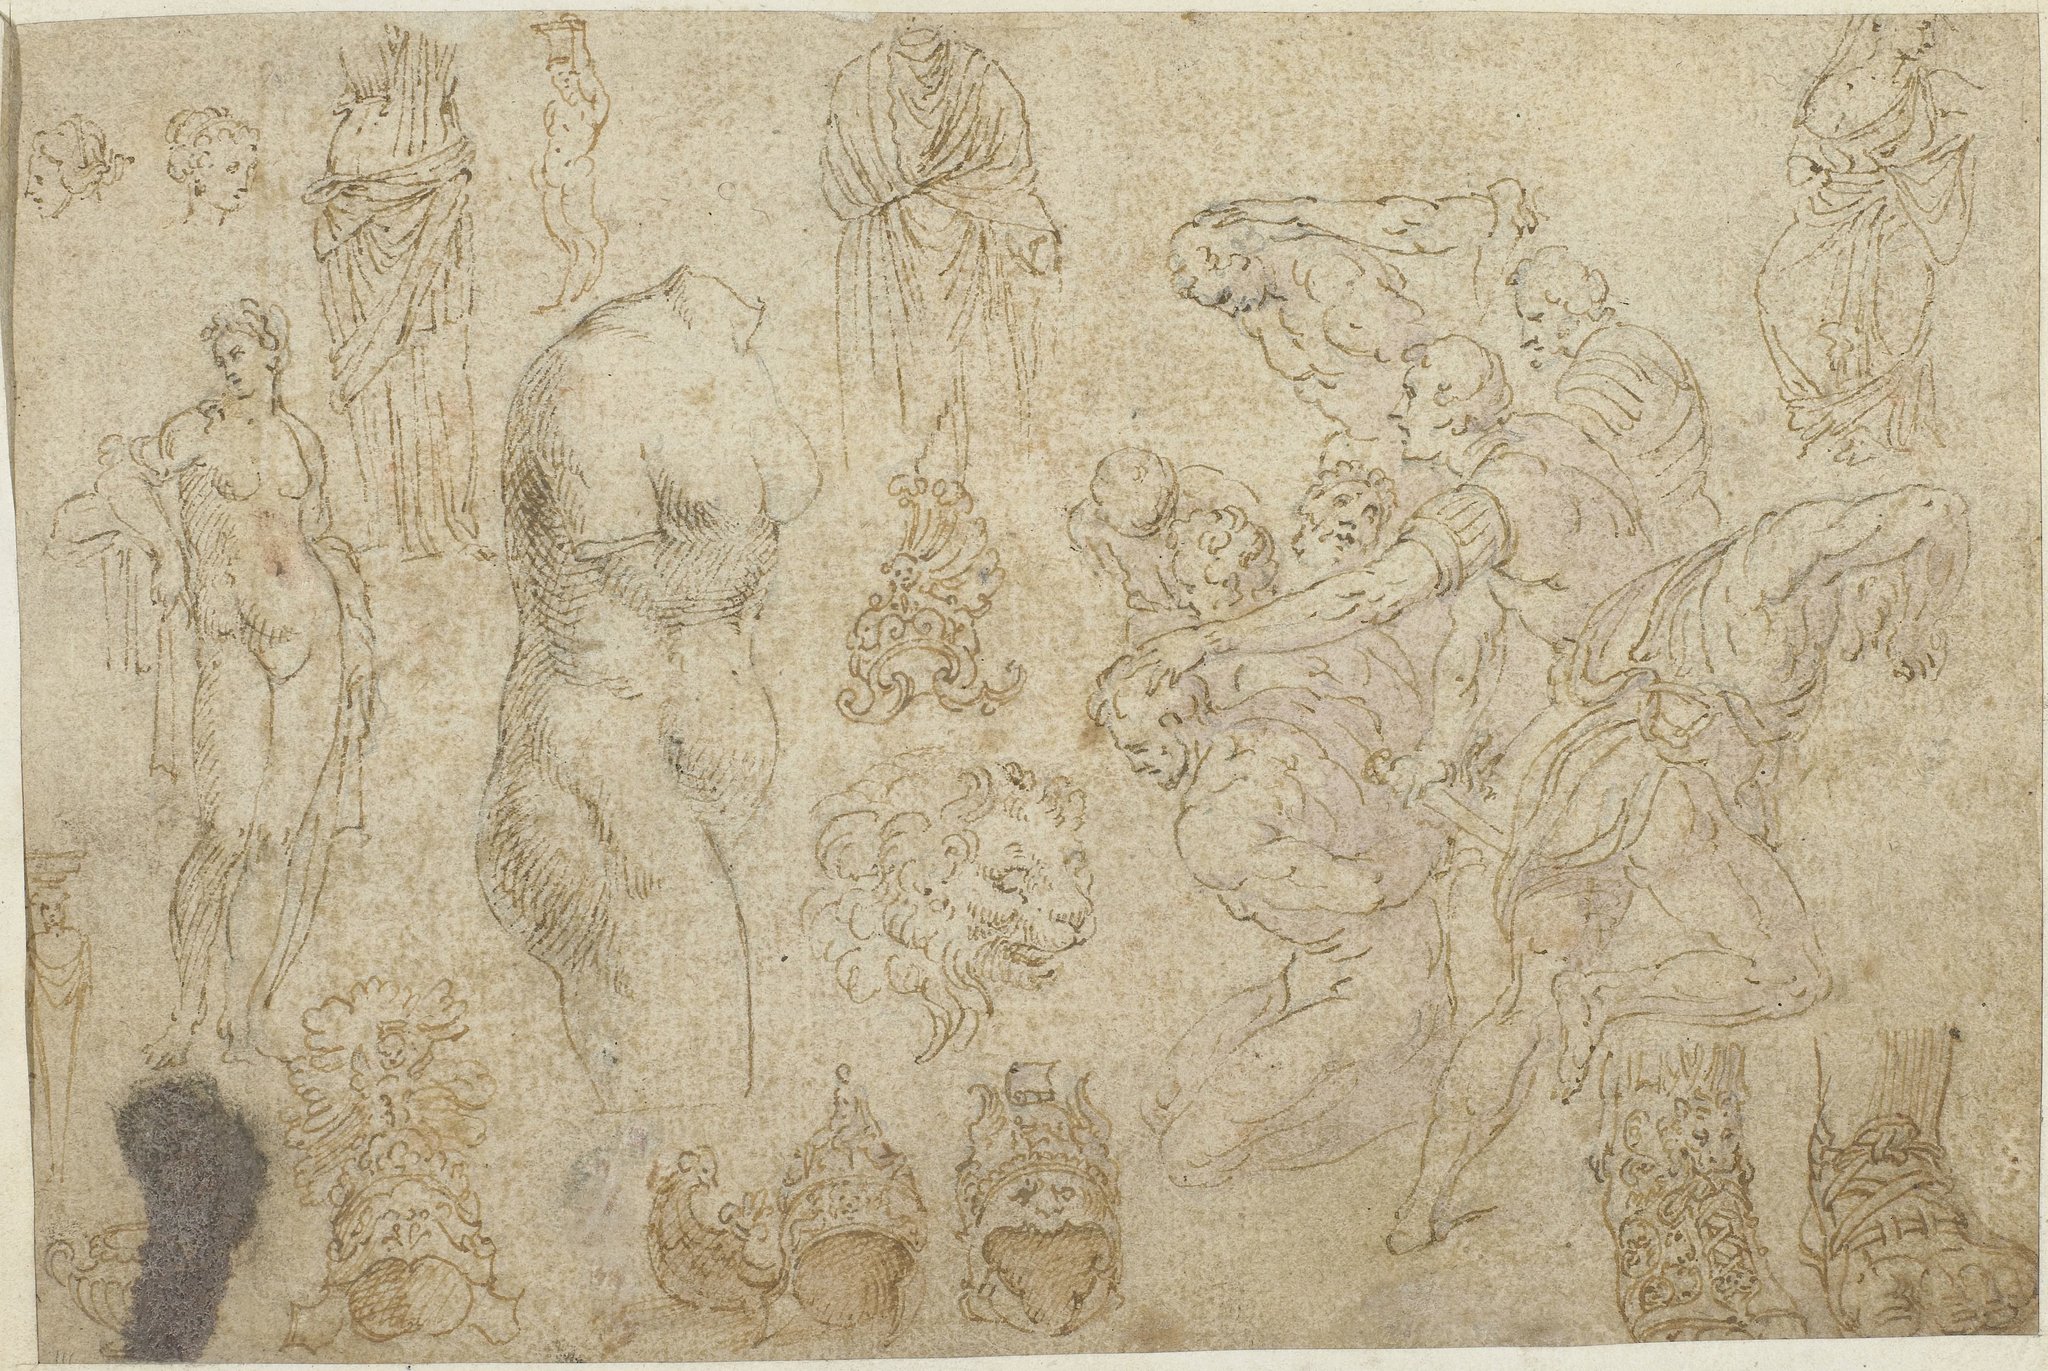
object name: kopie naar tekening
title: Beelden en fresco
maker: Anonymous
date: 1550-1570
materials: chalk, ink, paper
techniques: brush, pen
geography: low countries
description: Album "Maarten de Vos schetsboek", blad 4r(12)